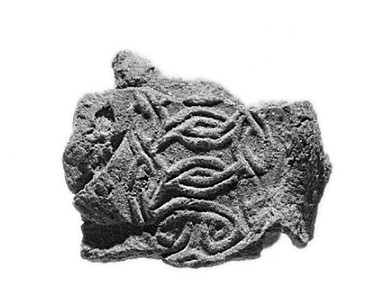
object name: sealing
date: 1981-1640 BCE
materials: mud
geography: egypt